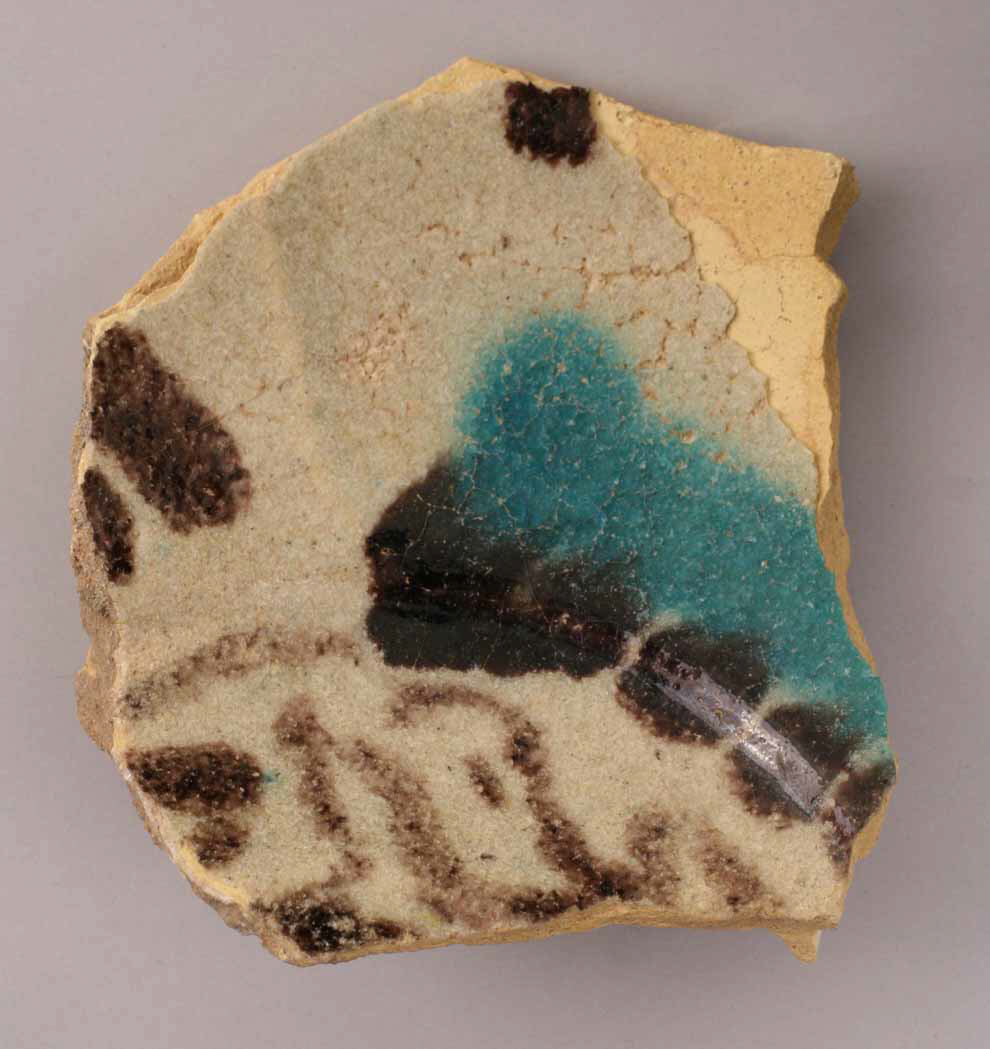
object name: fragment of a bowl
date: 801-900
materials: earthenware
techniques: glazing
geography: iraq